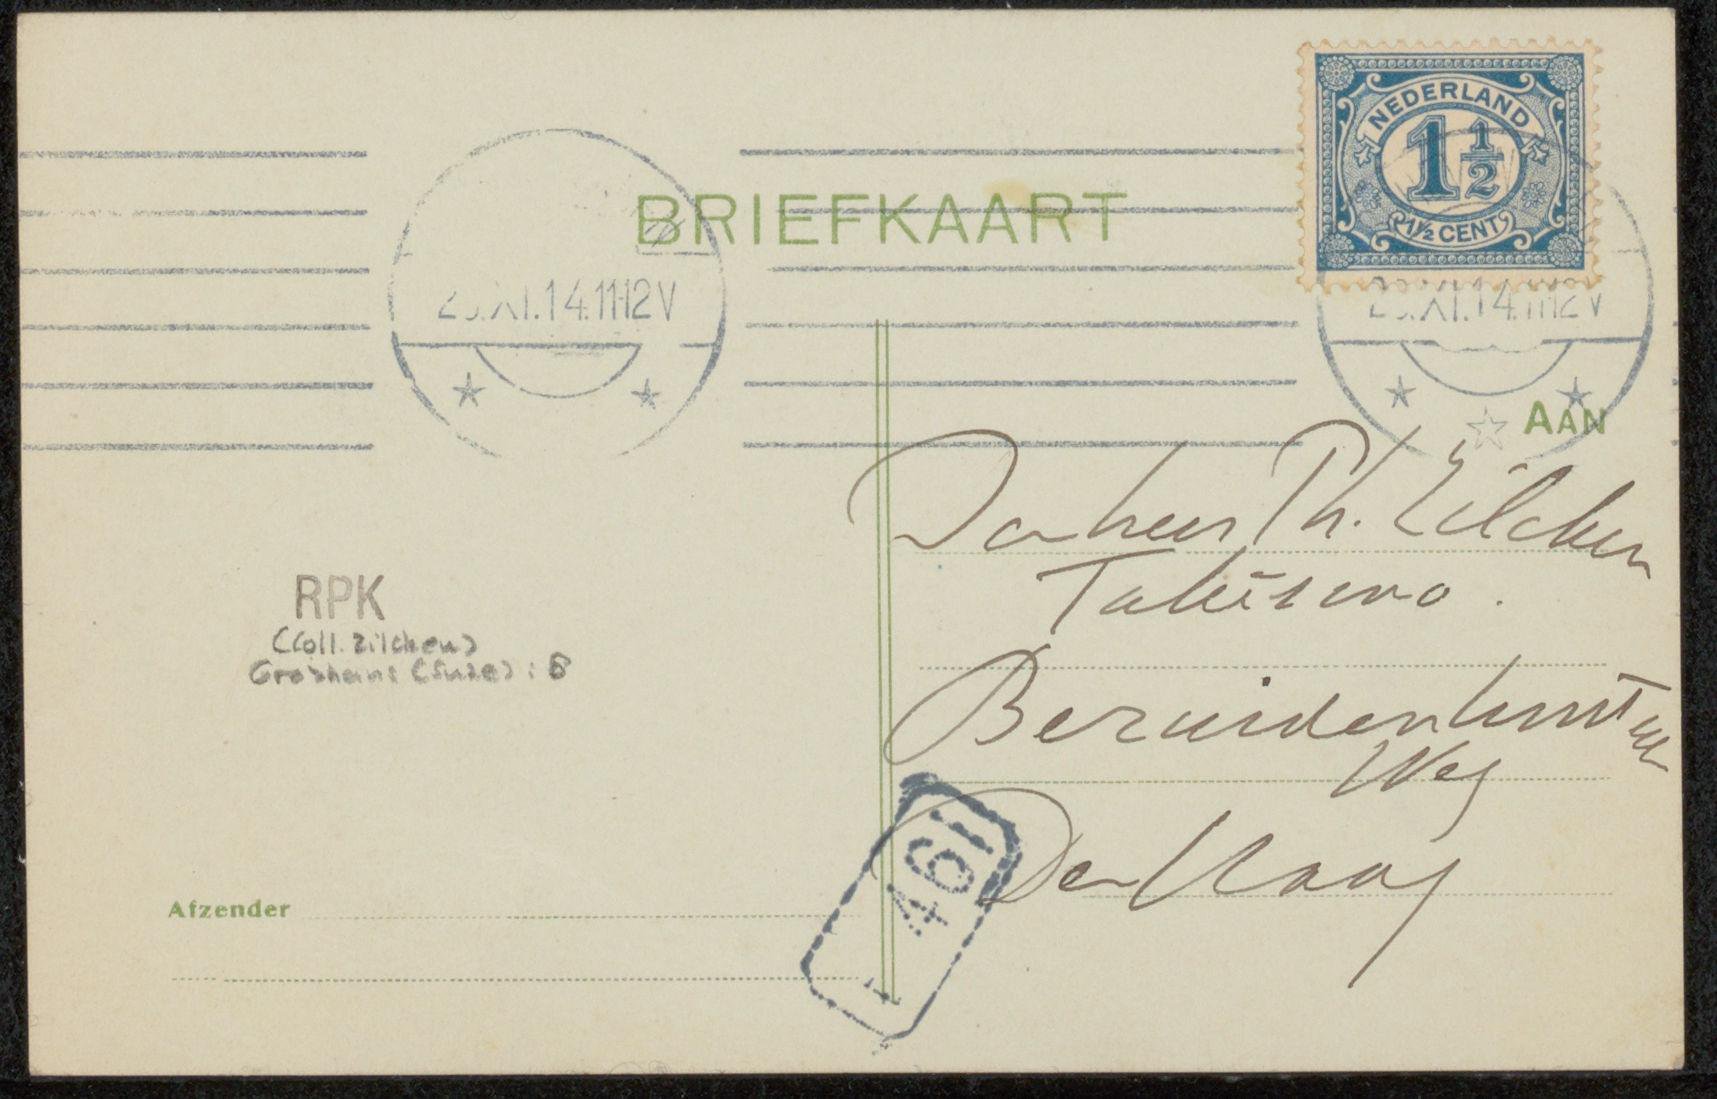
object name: postcard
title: Briefkaart aan Philip Zilcken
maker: suze groshans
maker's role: schrijver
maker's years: 1863-1944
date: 1914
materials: cardboard, ink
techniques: pen, writing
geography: scheveningen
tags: the hague, painter, draughtsman, philip zilcken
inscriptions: collector's mark: ‘RPK’